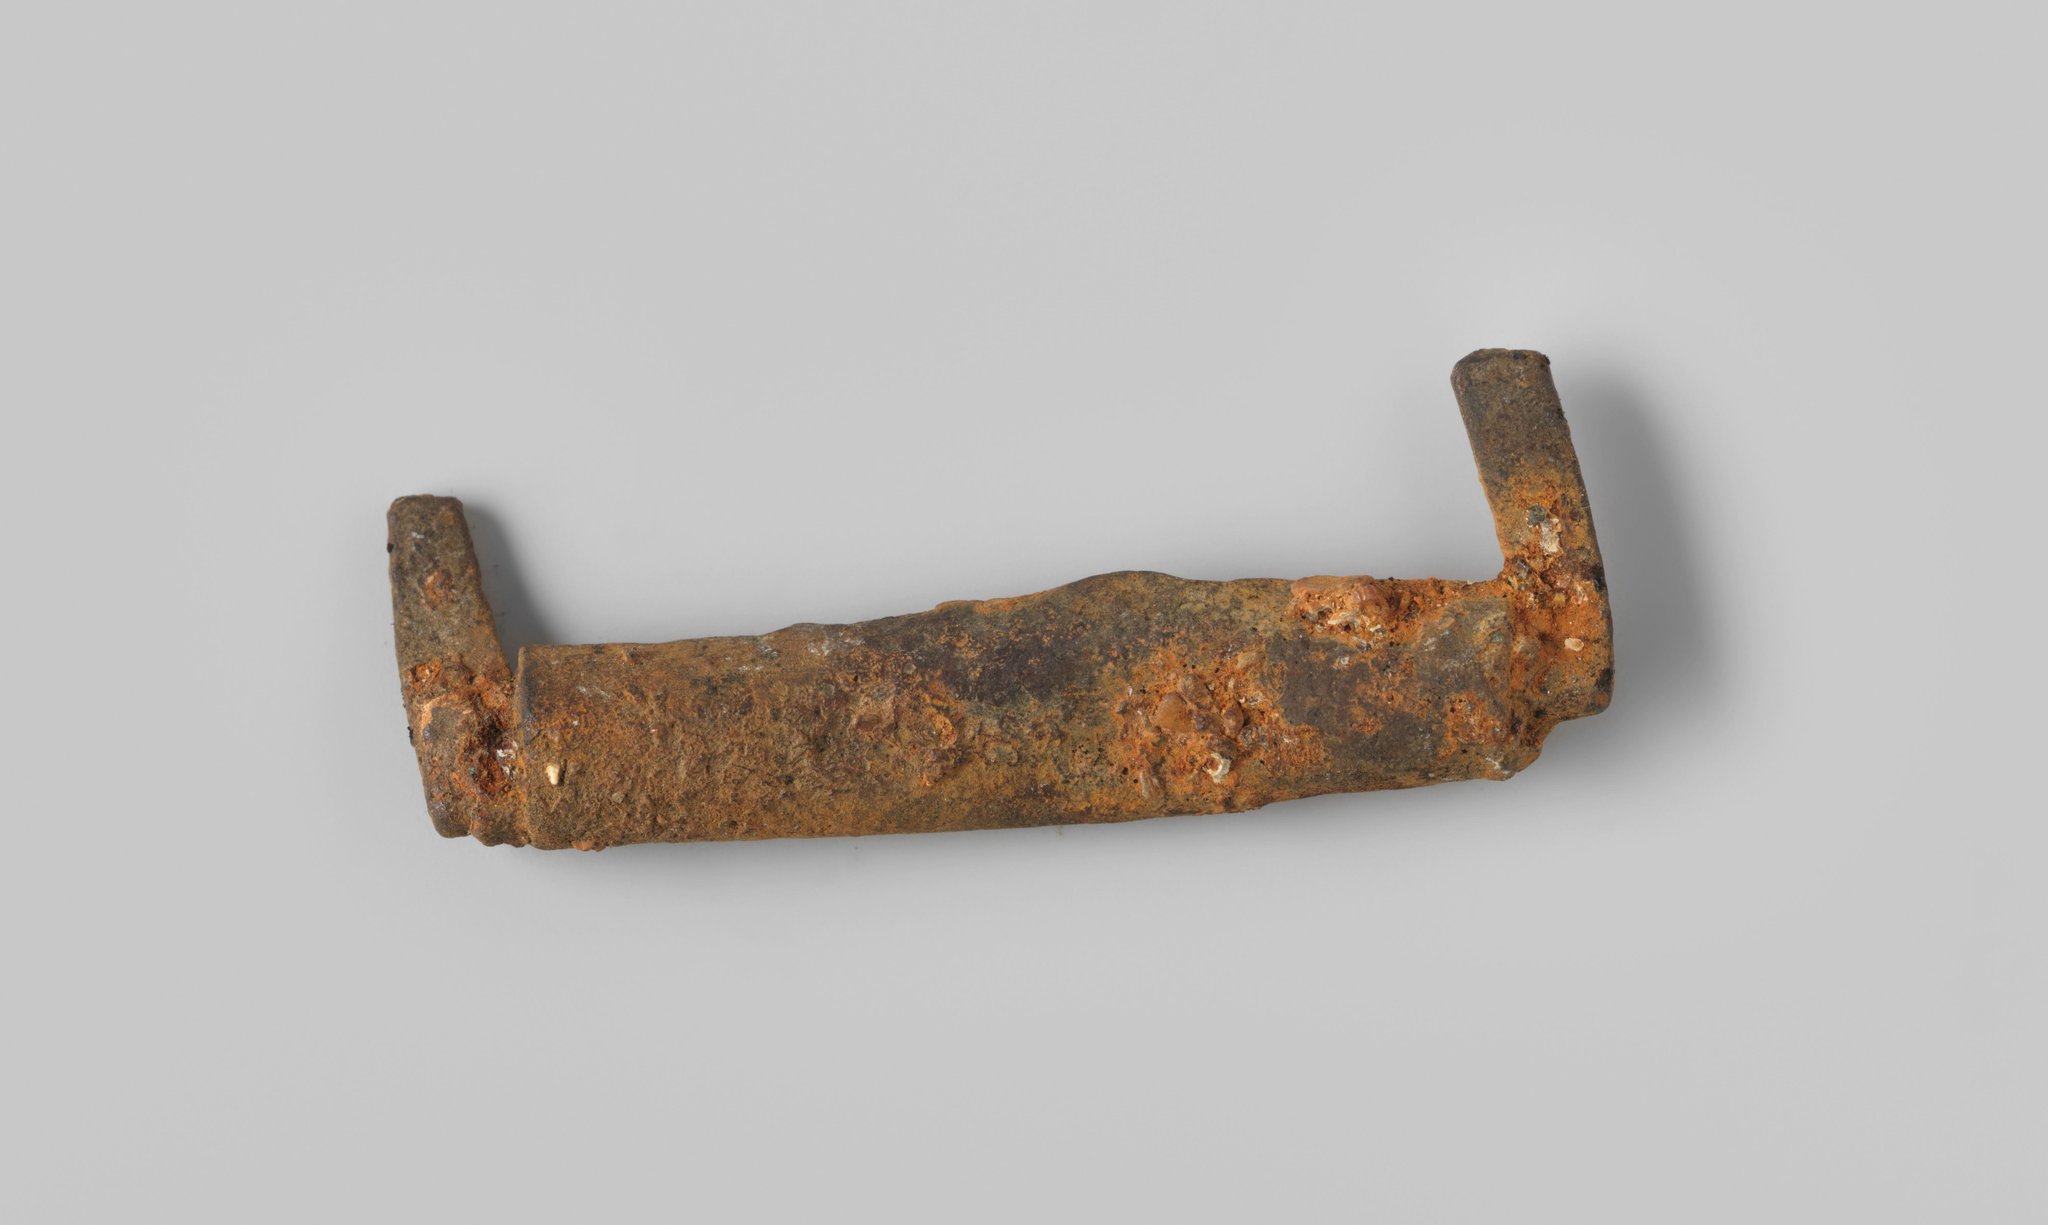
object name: belt buckle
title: Fragment riemgesp uit het wrak van de Oost-Indiëvaarder Hollandia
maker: Anonymous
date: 1700-1743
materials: copper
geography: netherlands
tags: verenigde oostindische compagnie, hollandia (schip), annet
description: D-shaped, fragm of ring, id., belt buckle.